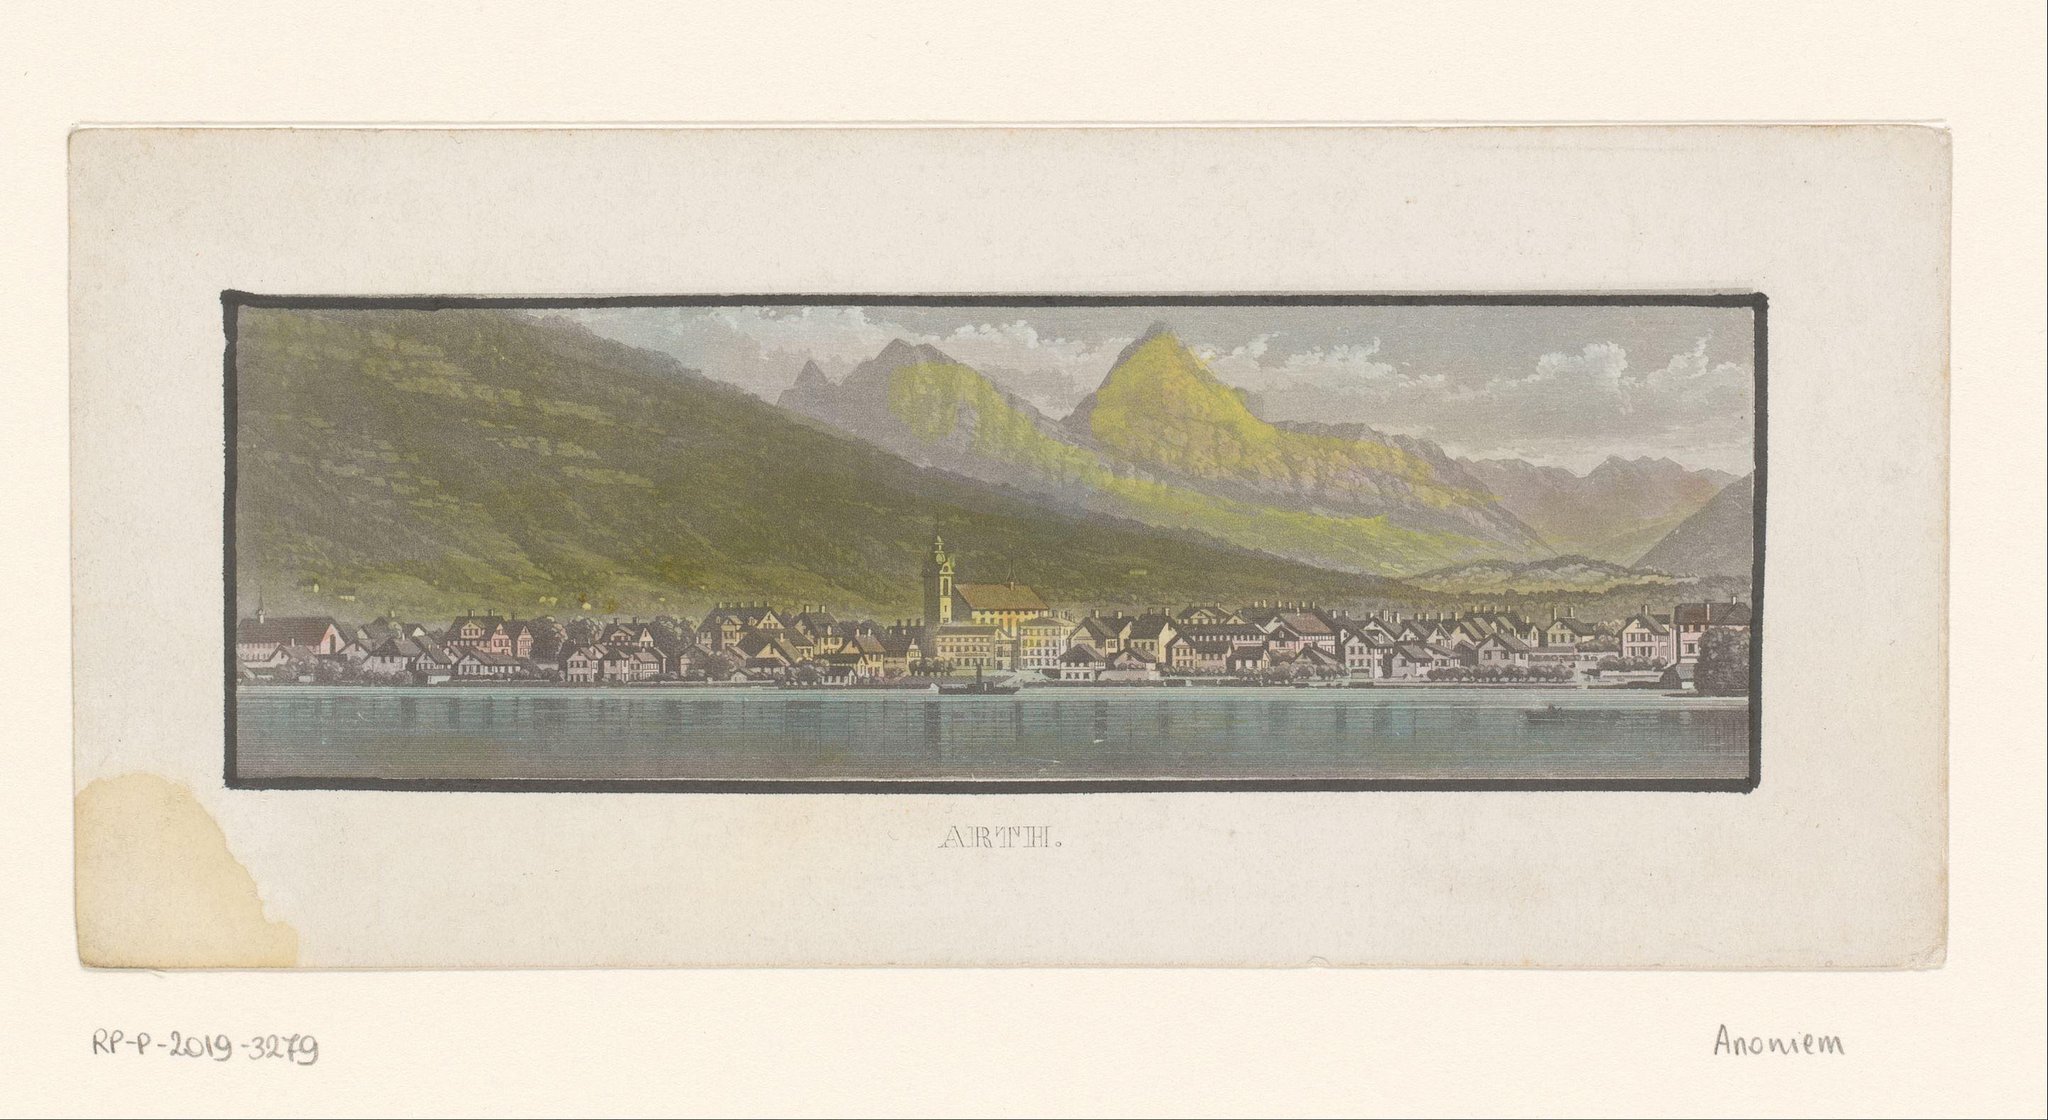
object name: print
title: Gezicht op Arth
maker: Anonymous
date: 1800-1899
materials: paper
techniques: aquatint, etching, hand coloring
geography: switzerland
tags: lake, outskirts of city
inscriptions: collector's mark: ‘L.A. De Vries’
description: Maakt waarschijnlijk deel uit van een serie met Zwitserse landschappen.